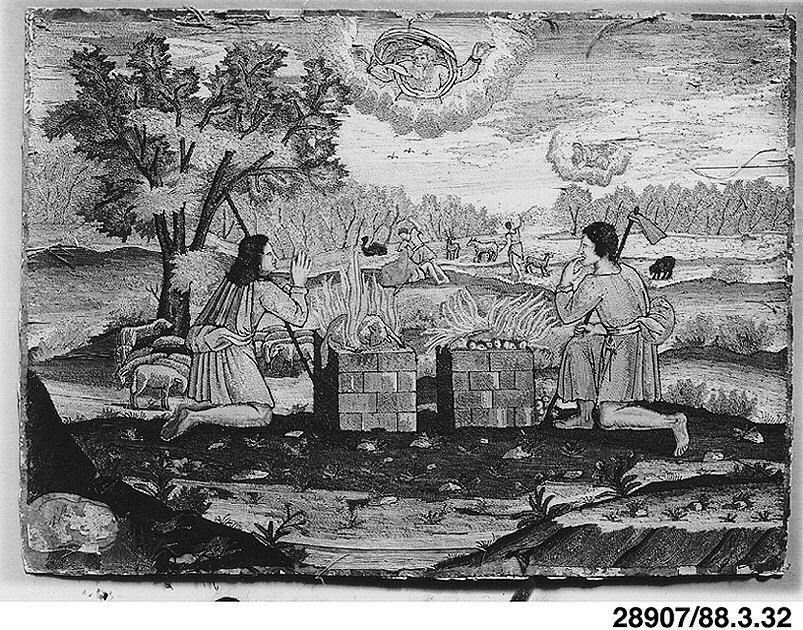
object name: embroidered picture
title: Offerings of Cain and Abel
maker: leonardus quesi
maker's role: maker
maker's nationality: french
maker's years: 1650-1750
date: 1667-1700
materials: cardboard, silk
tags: animals,trees,abel,cain